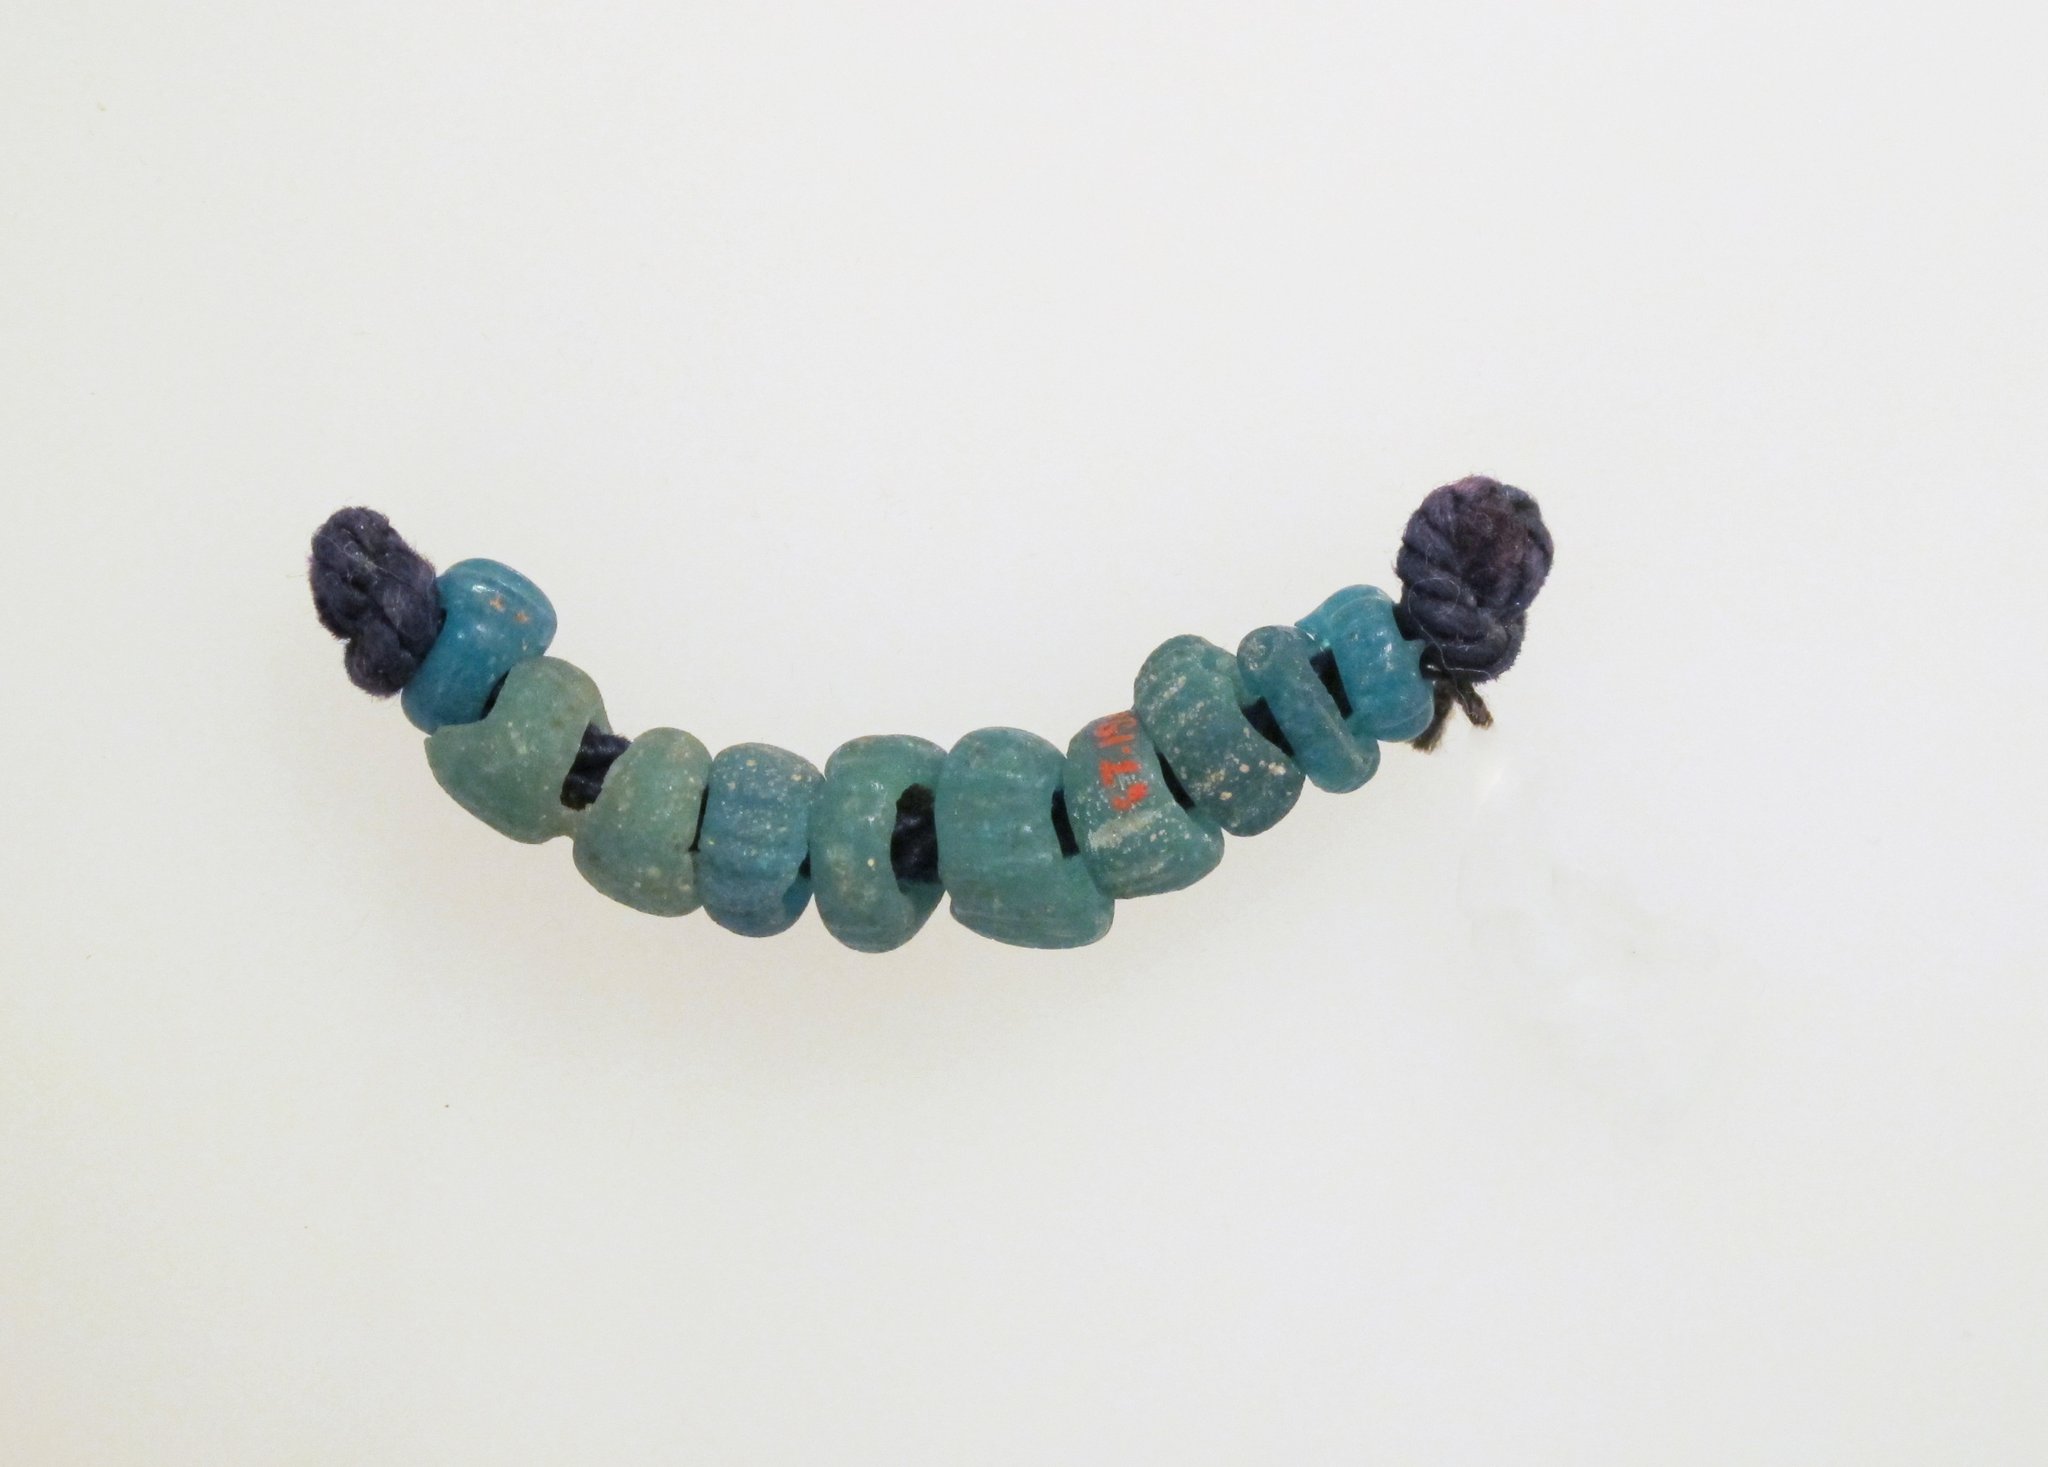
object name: bead, 10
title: Beads, 10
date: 7000 BCE-330 CE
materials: glass